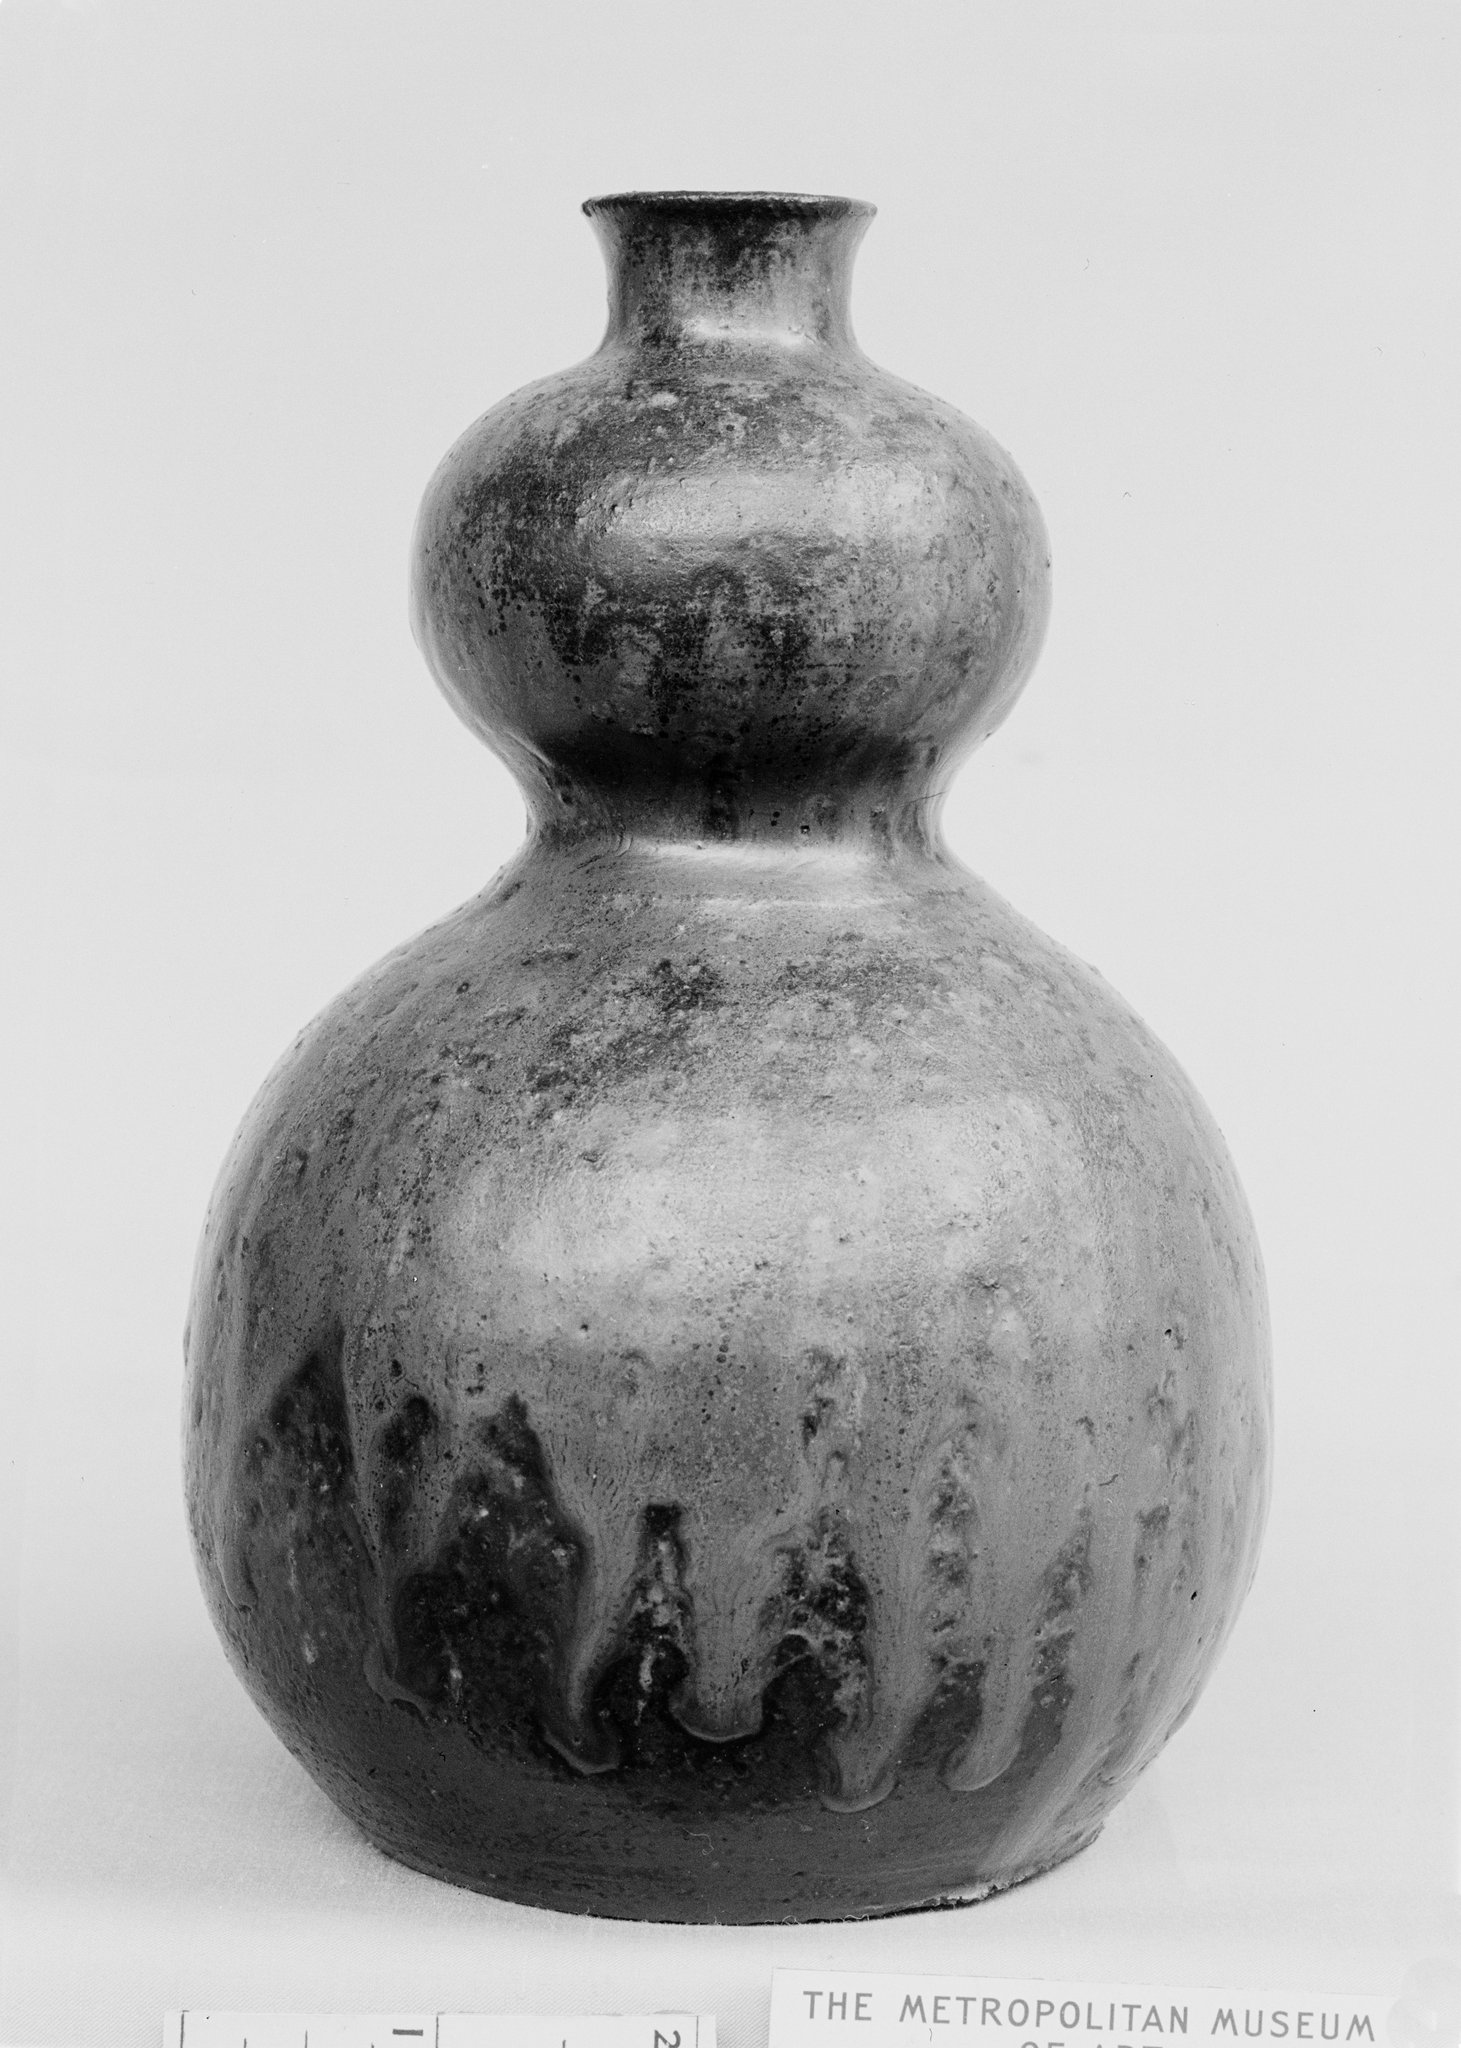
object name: bottle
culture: japanese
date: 1801-1900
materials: clay, glaze